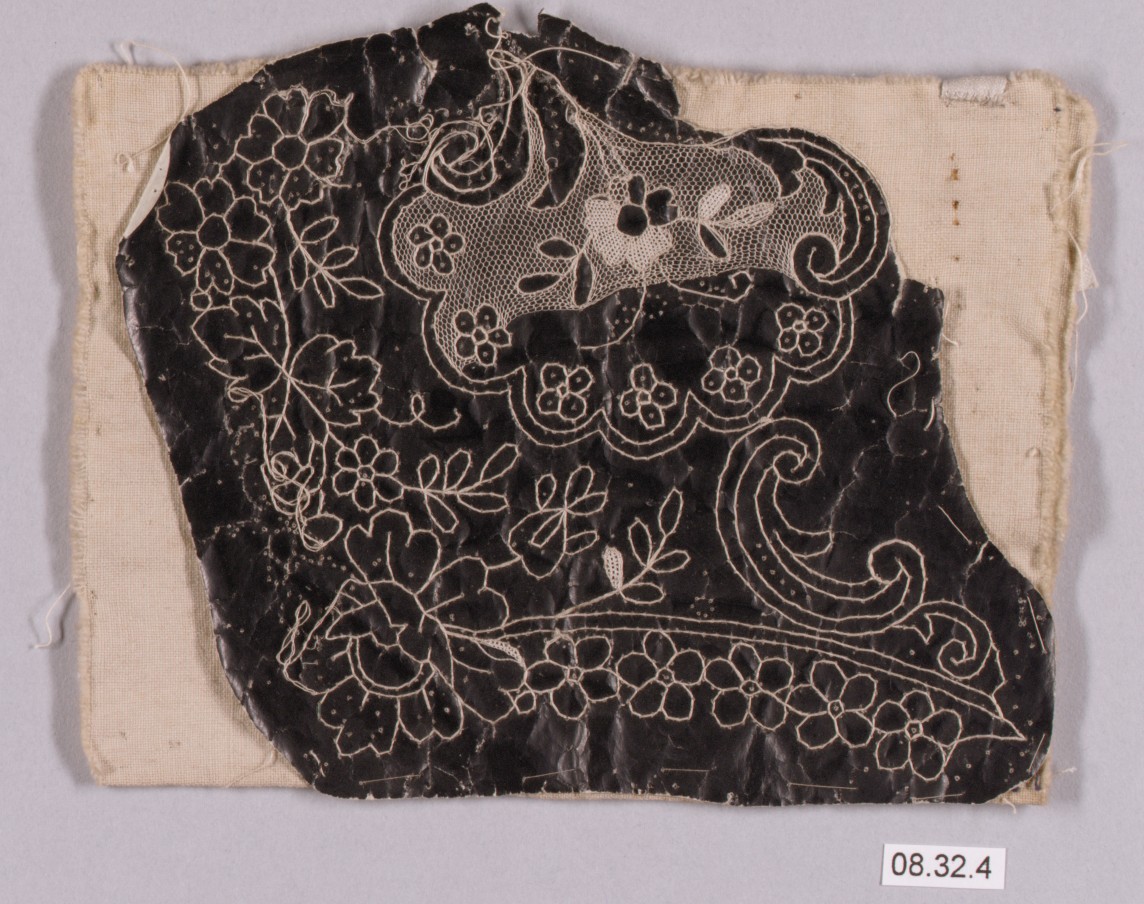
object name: pattern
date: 1801-1900